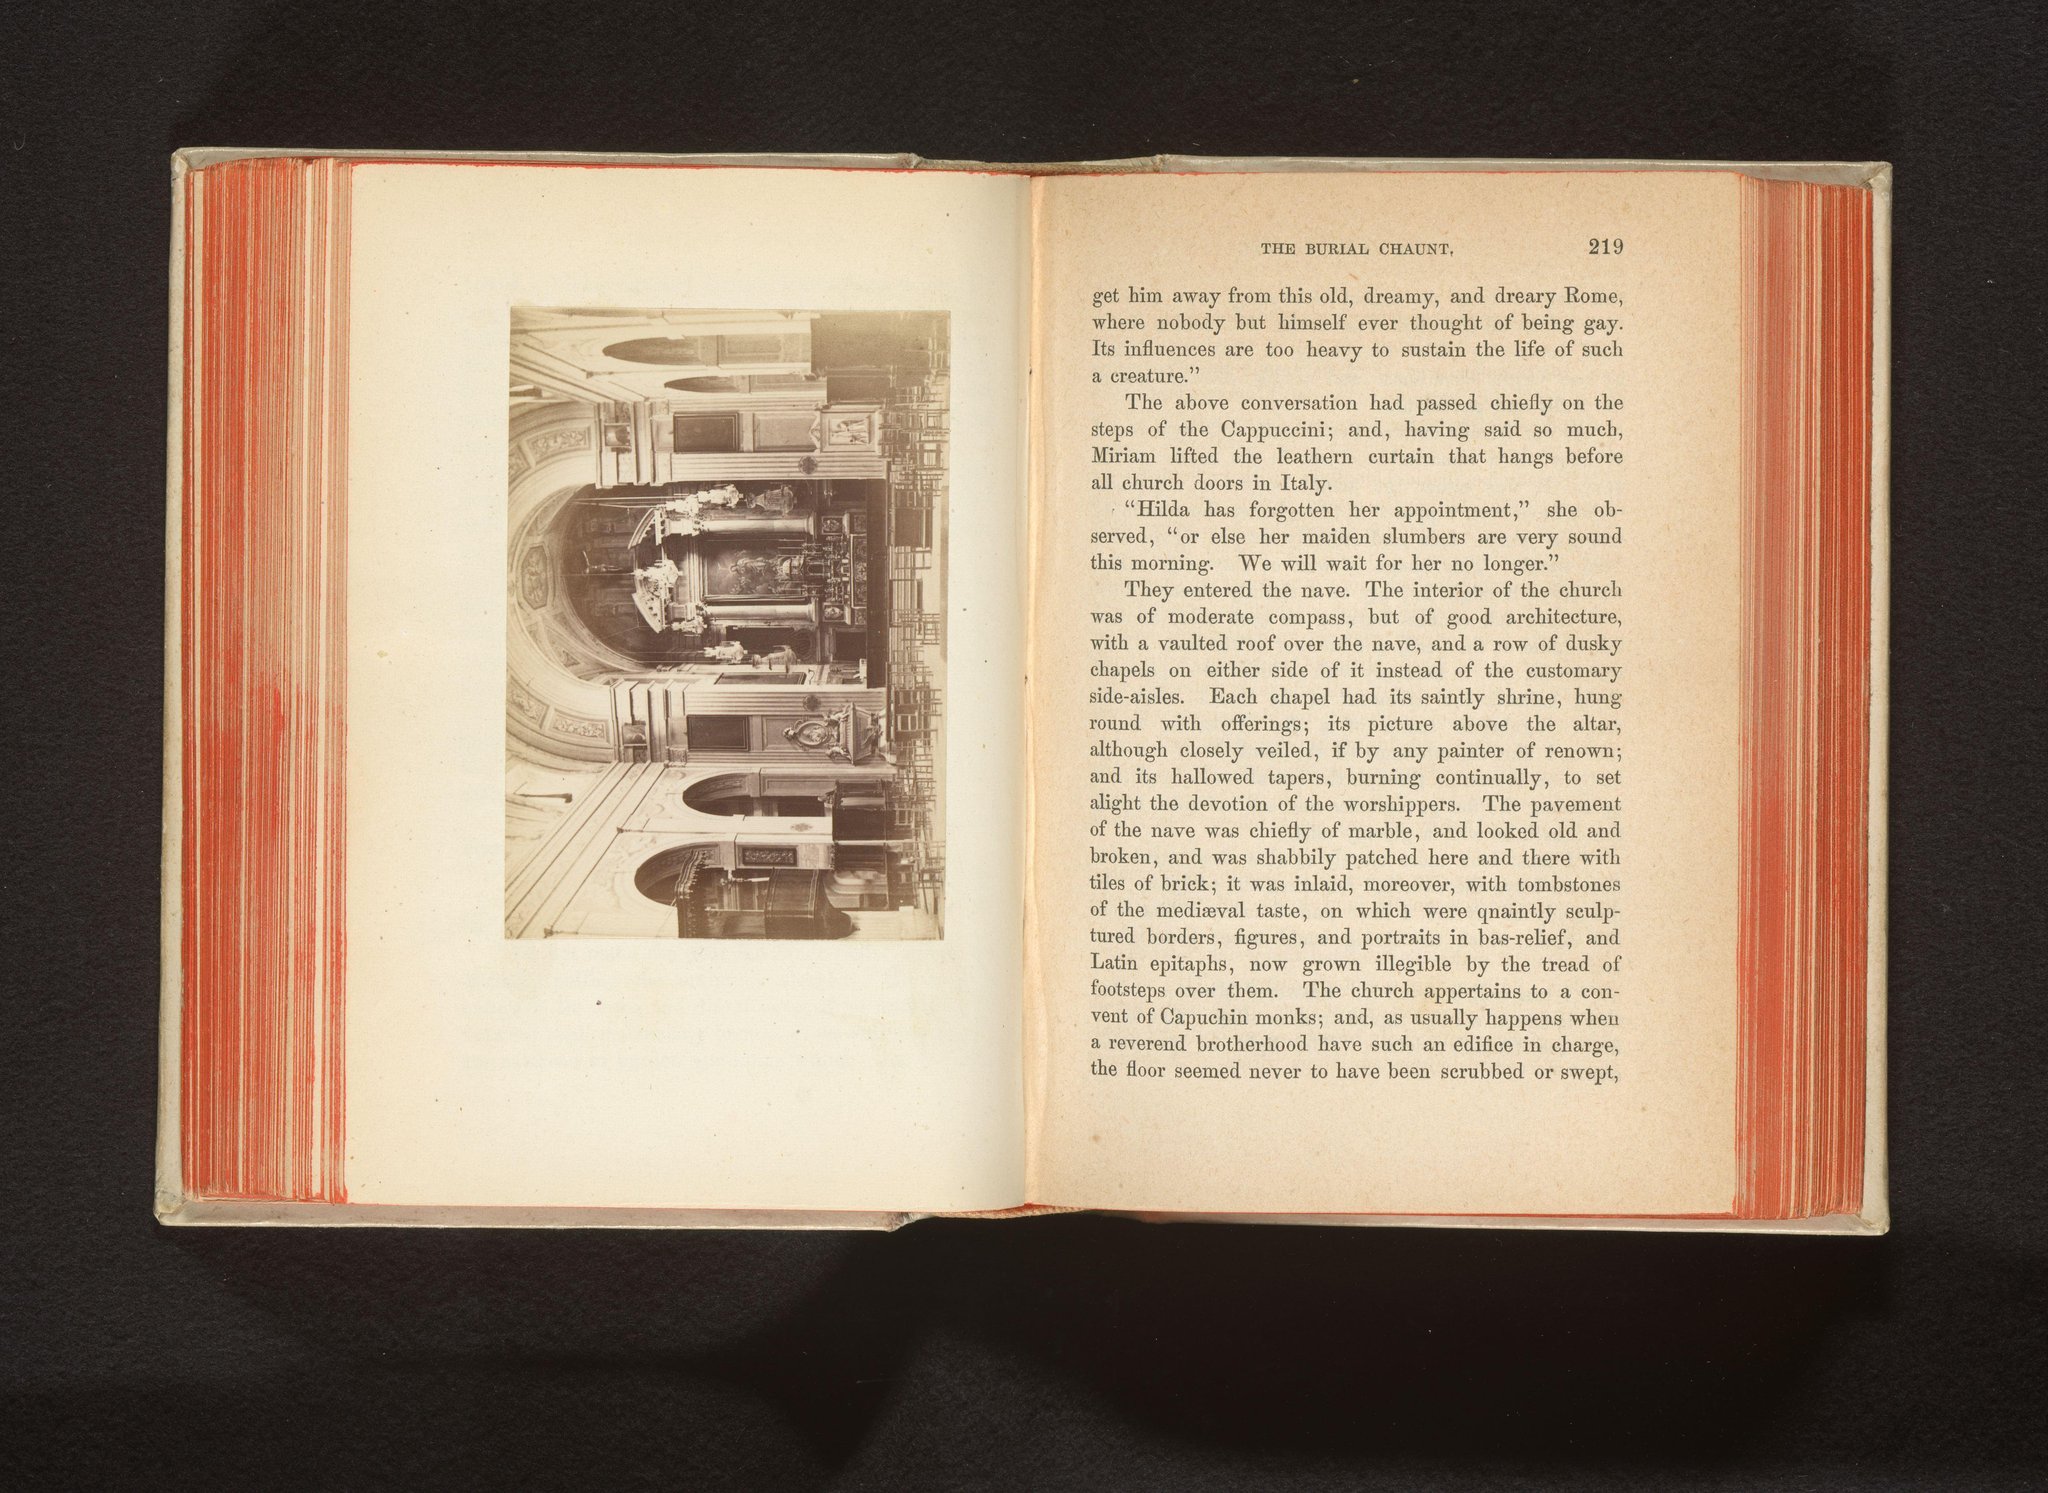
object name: photograph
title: Interieur van de Santa Maria della Concezione dei Cappuccini in Rome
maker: Anonymous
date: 1850-1860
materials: photographic support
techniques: albumen print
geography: santa maria della concezione dei cappuccini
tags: interior of church, altar with altar-piece